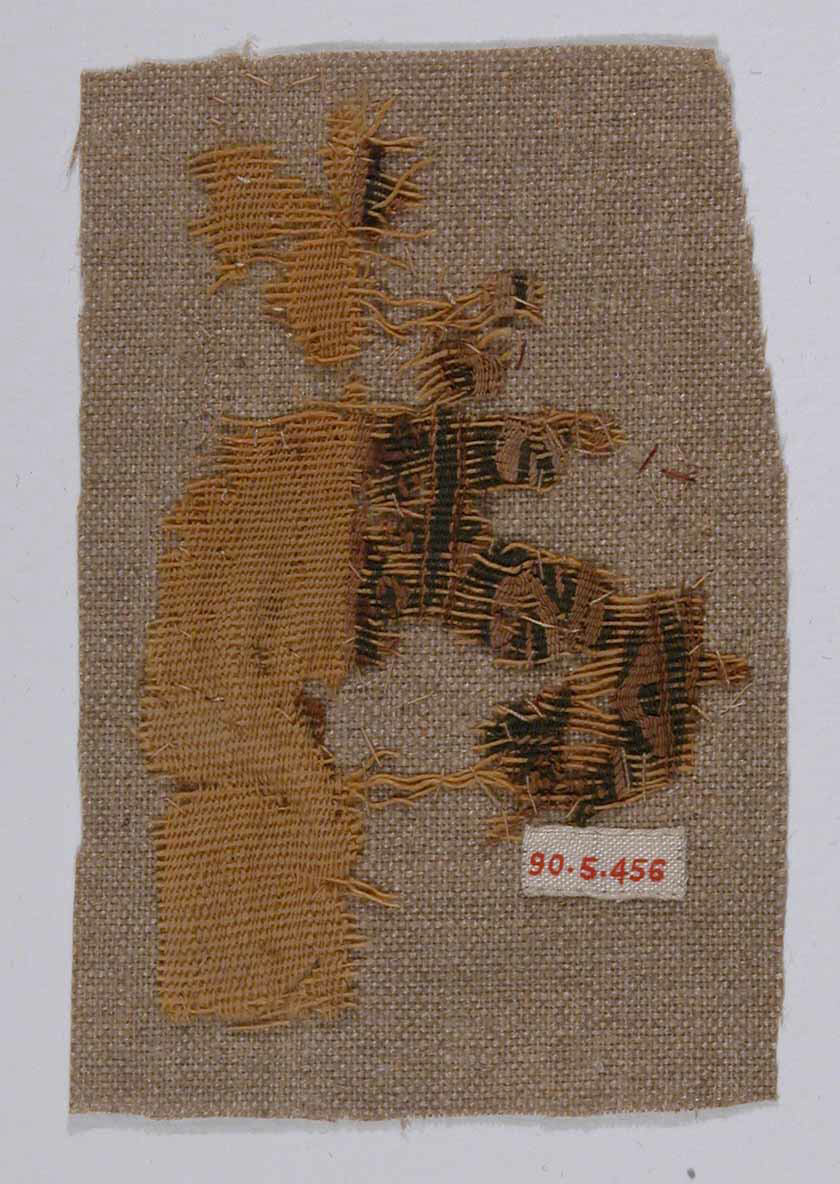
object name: textile fragment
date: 301-500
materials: linen, wool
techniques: weave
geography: egypt